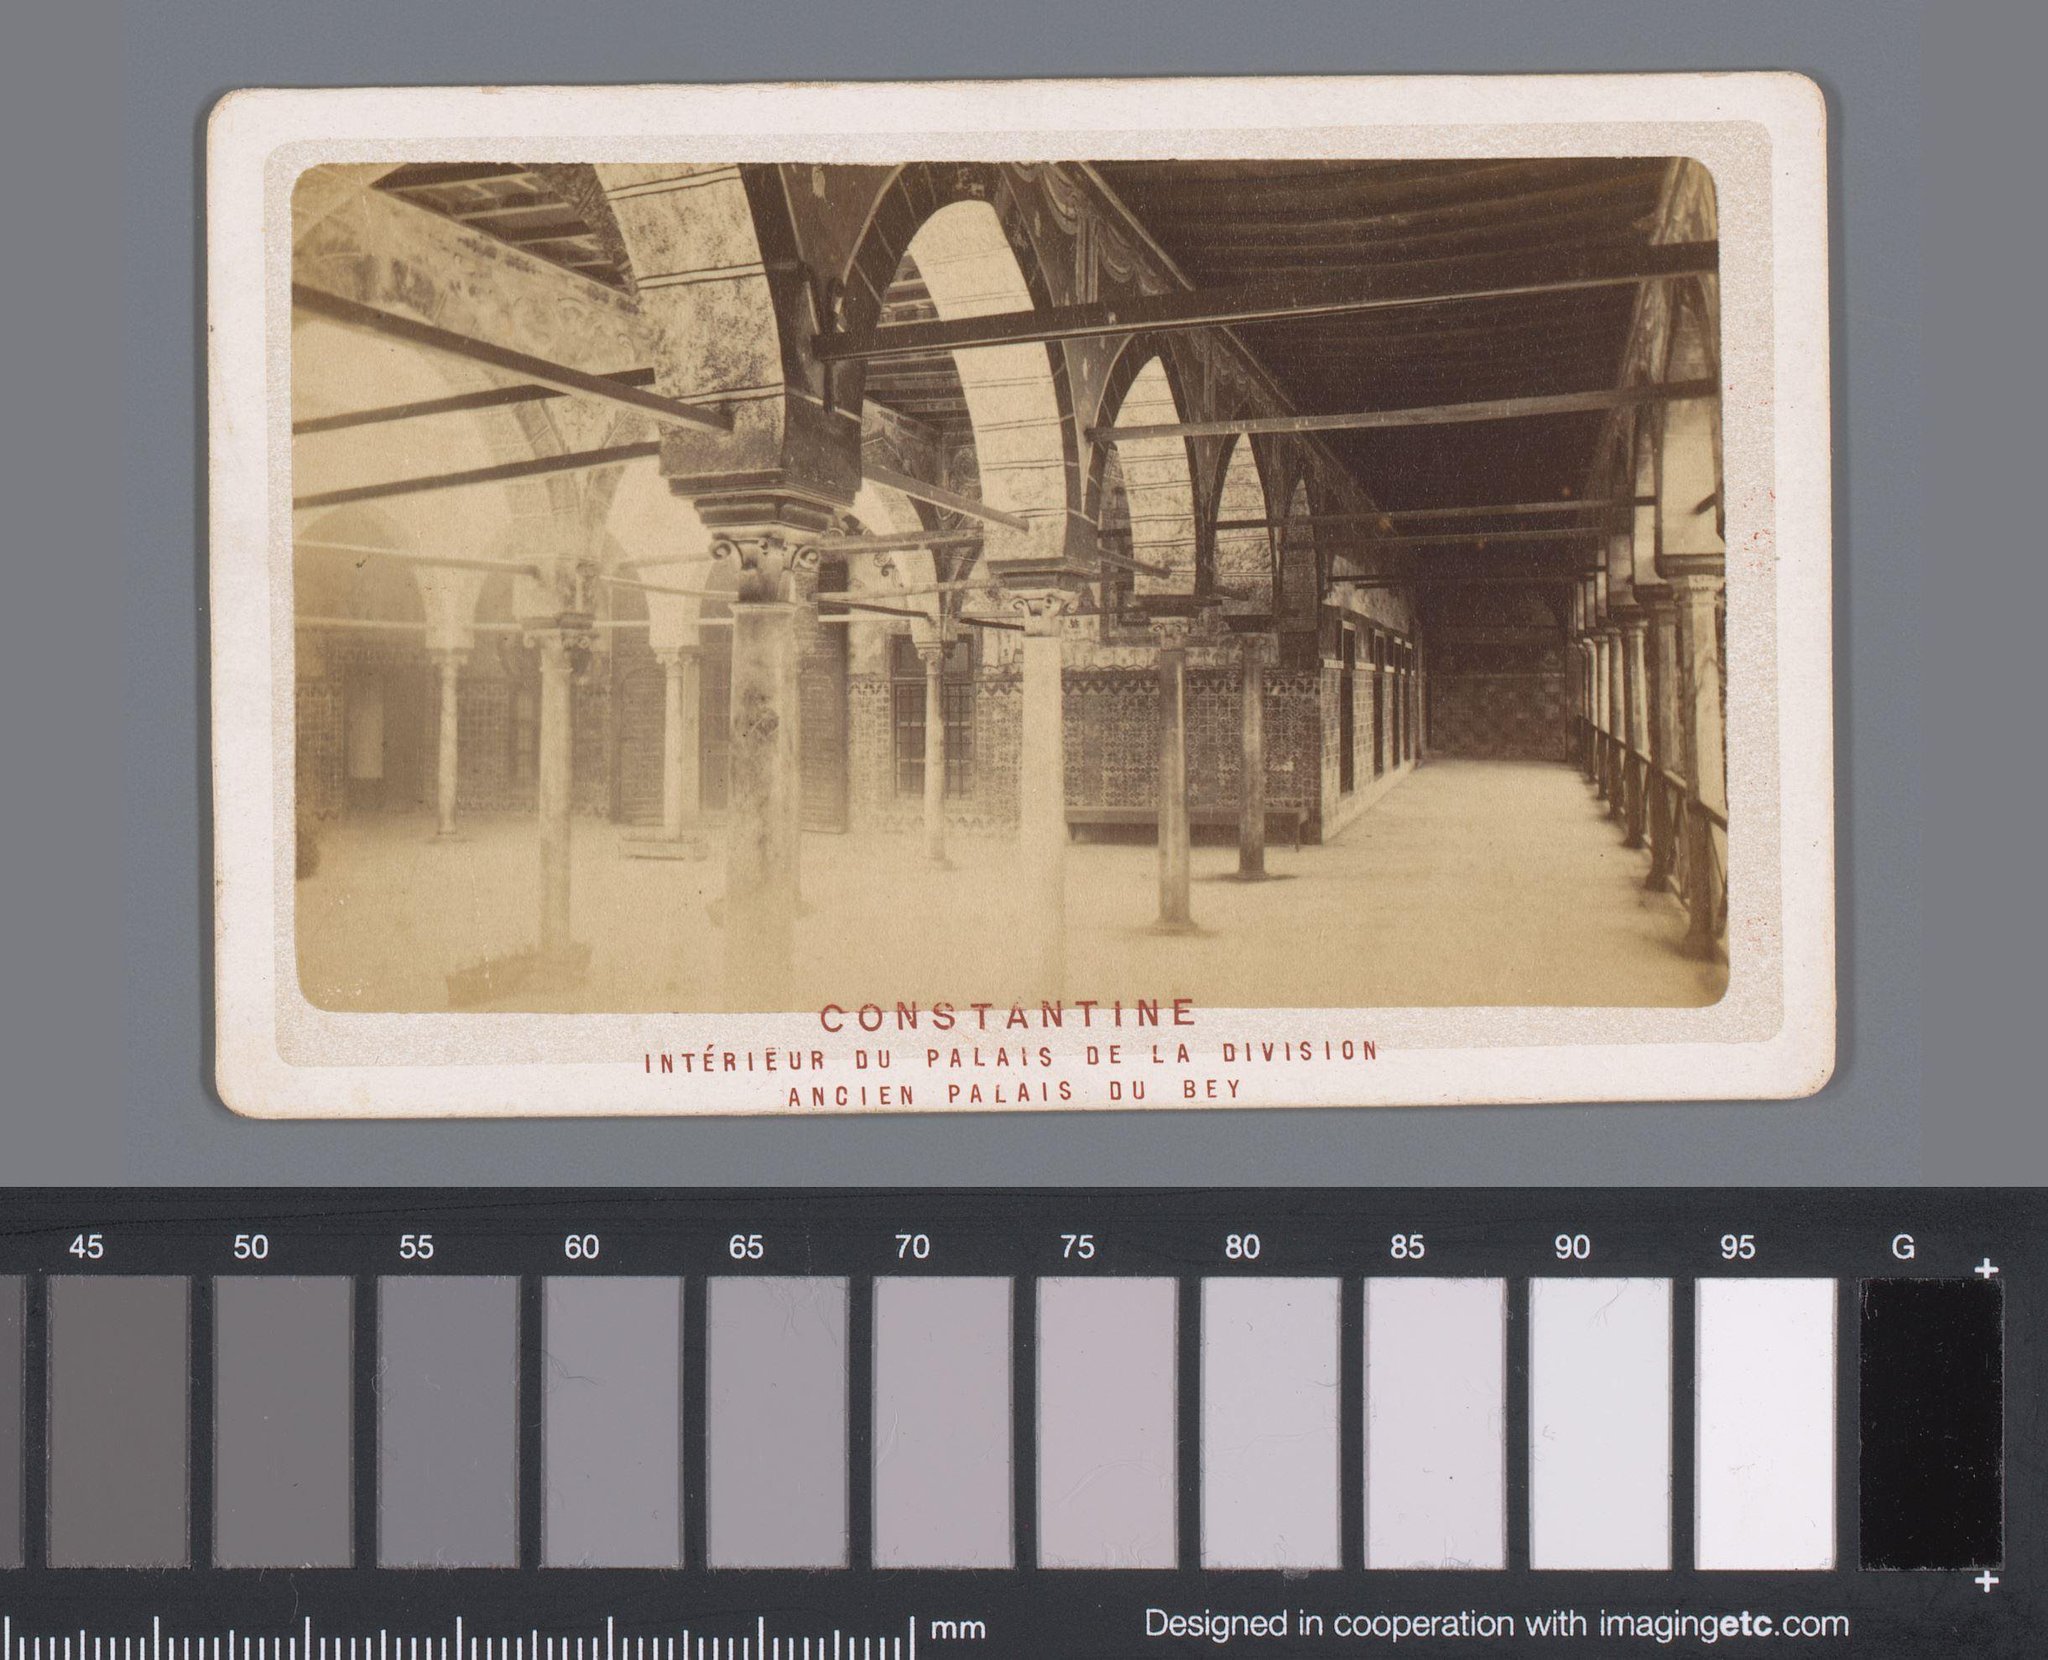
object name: photograph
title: Paleisinterieur in Constantine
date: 1855-1885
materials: paper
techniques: albumen print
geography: paris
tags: palace - aa - civic architecture: inside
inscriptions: inscription: ‘E. Neurdein - Editeur. Paris’